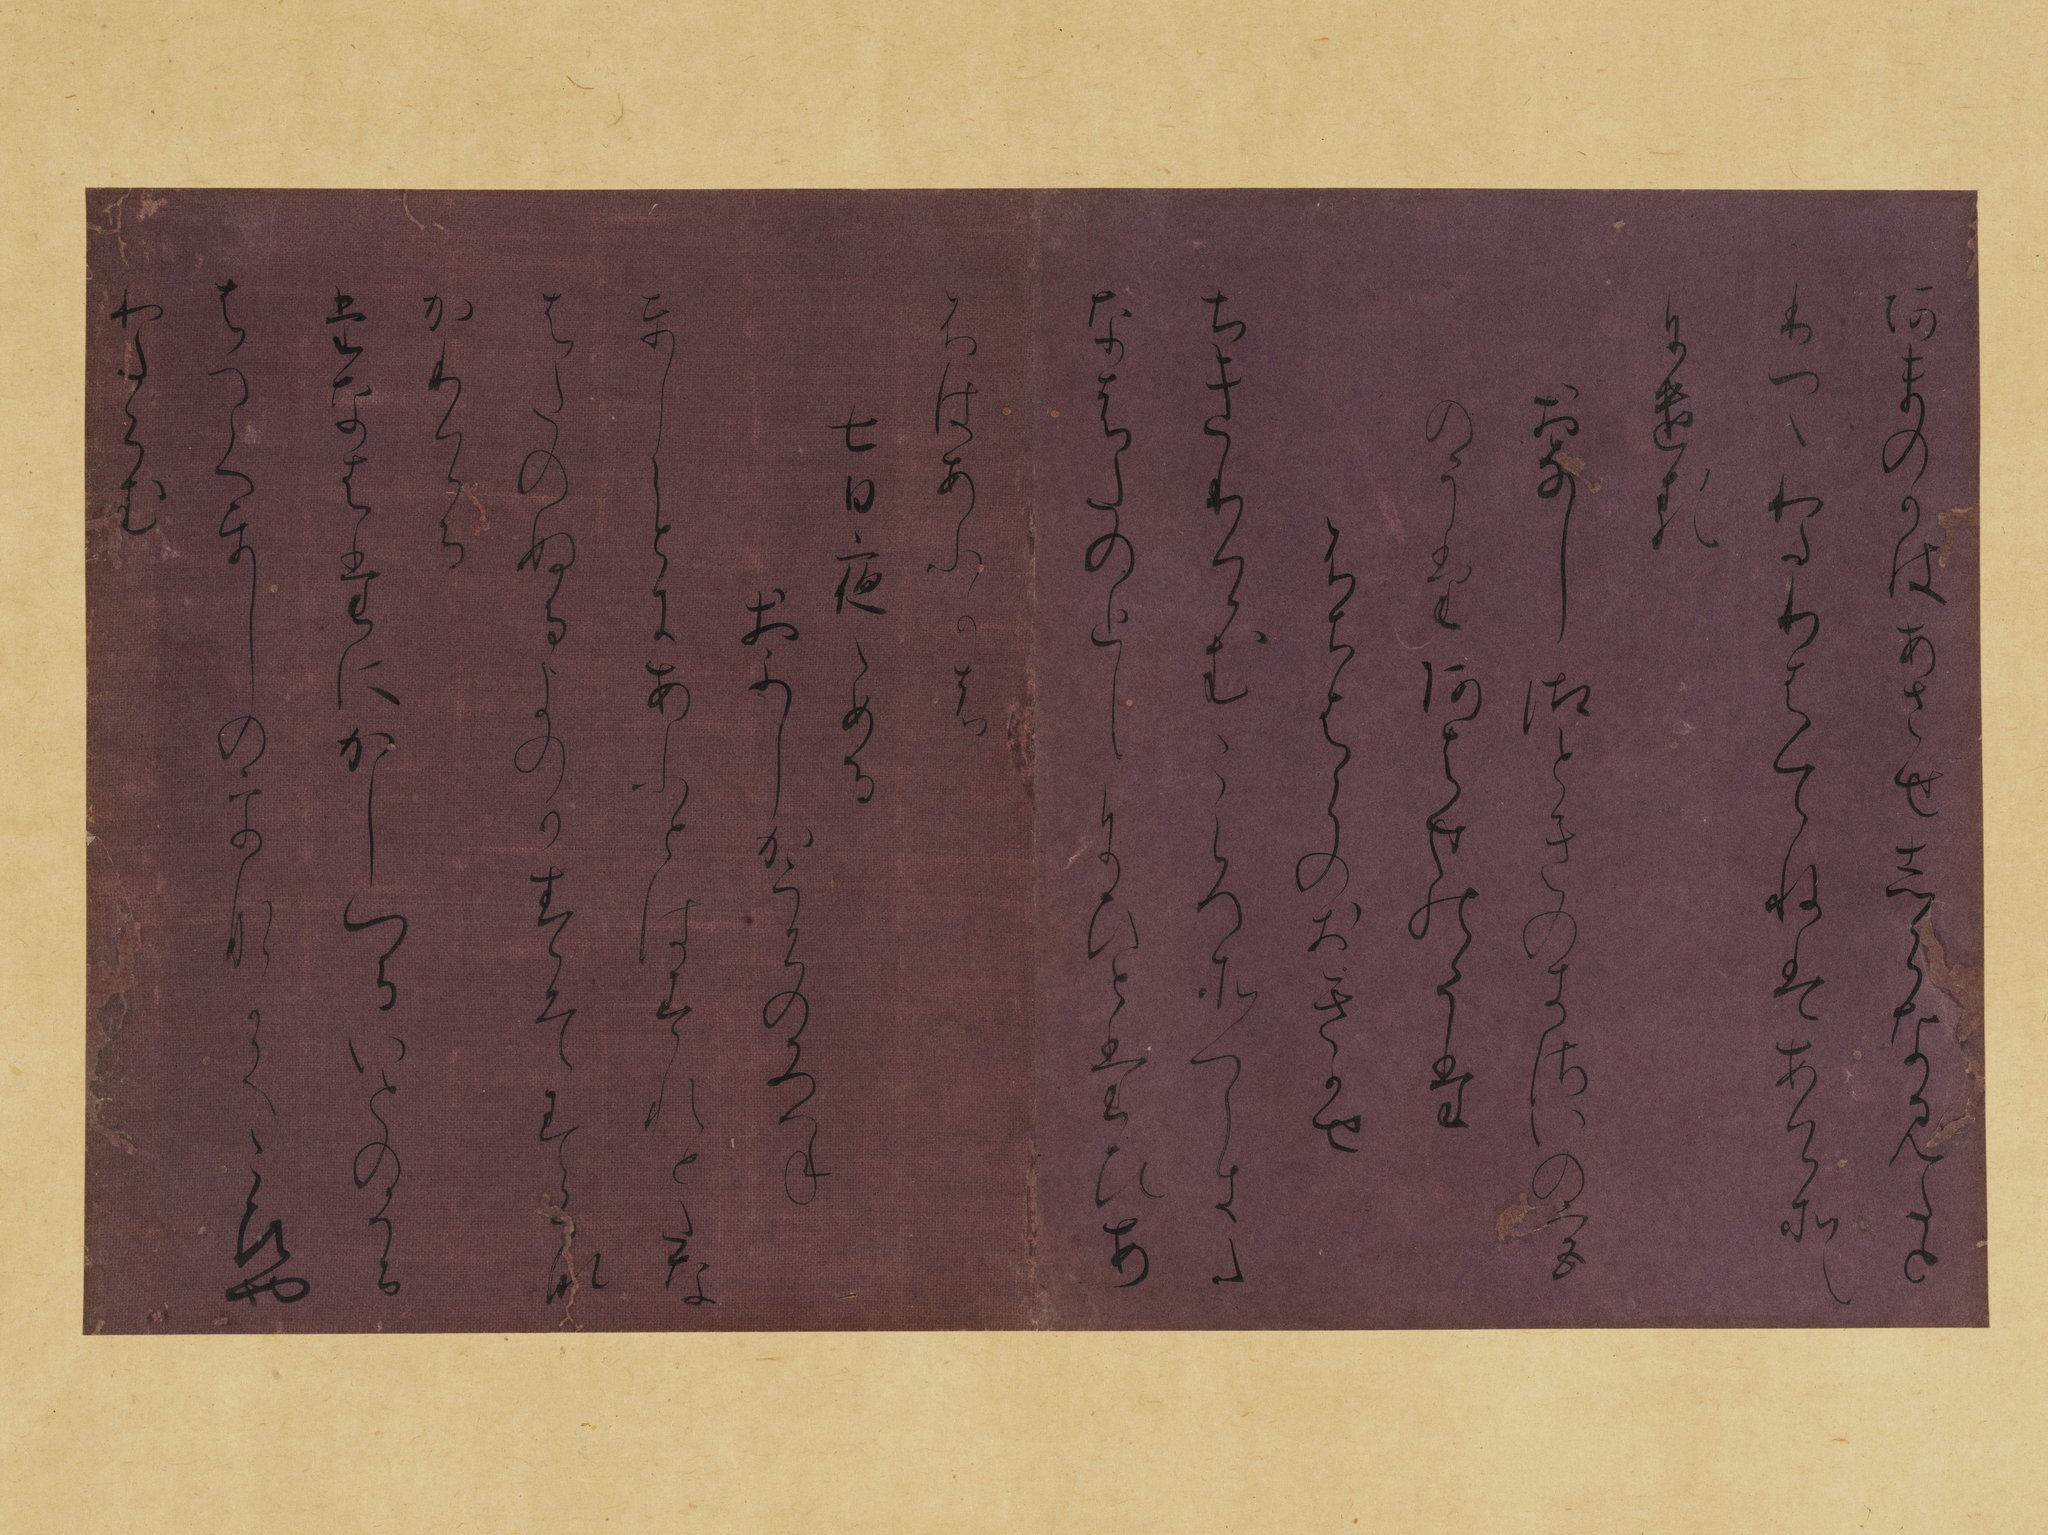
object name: hanging scroll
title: Four Poems from the Sekido Version of the Collection of Poems Ancient and Modern (Sekido-bon Kokin wakashū)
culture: japanese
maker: fujiwara no yukinari 藤原行成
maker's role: artist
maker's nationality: japanese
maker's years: 972-1027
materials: ink, paper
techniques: dyeing